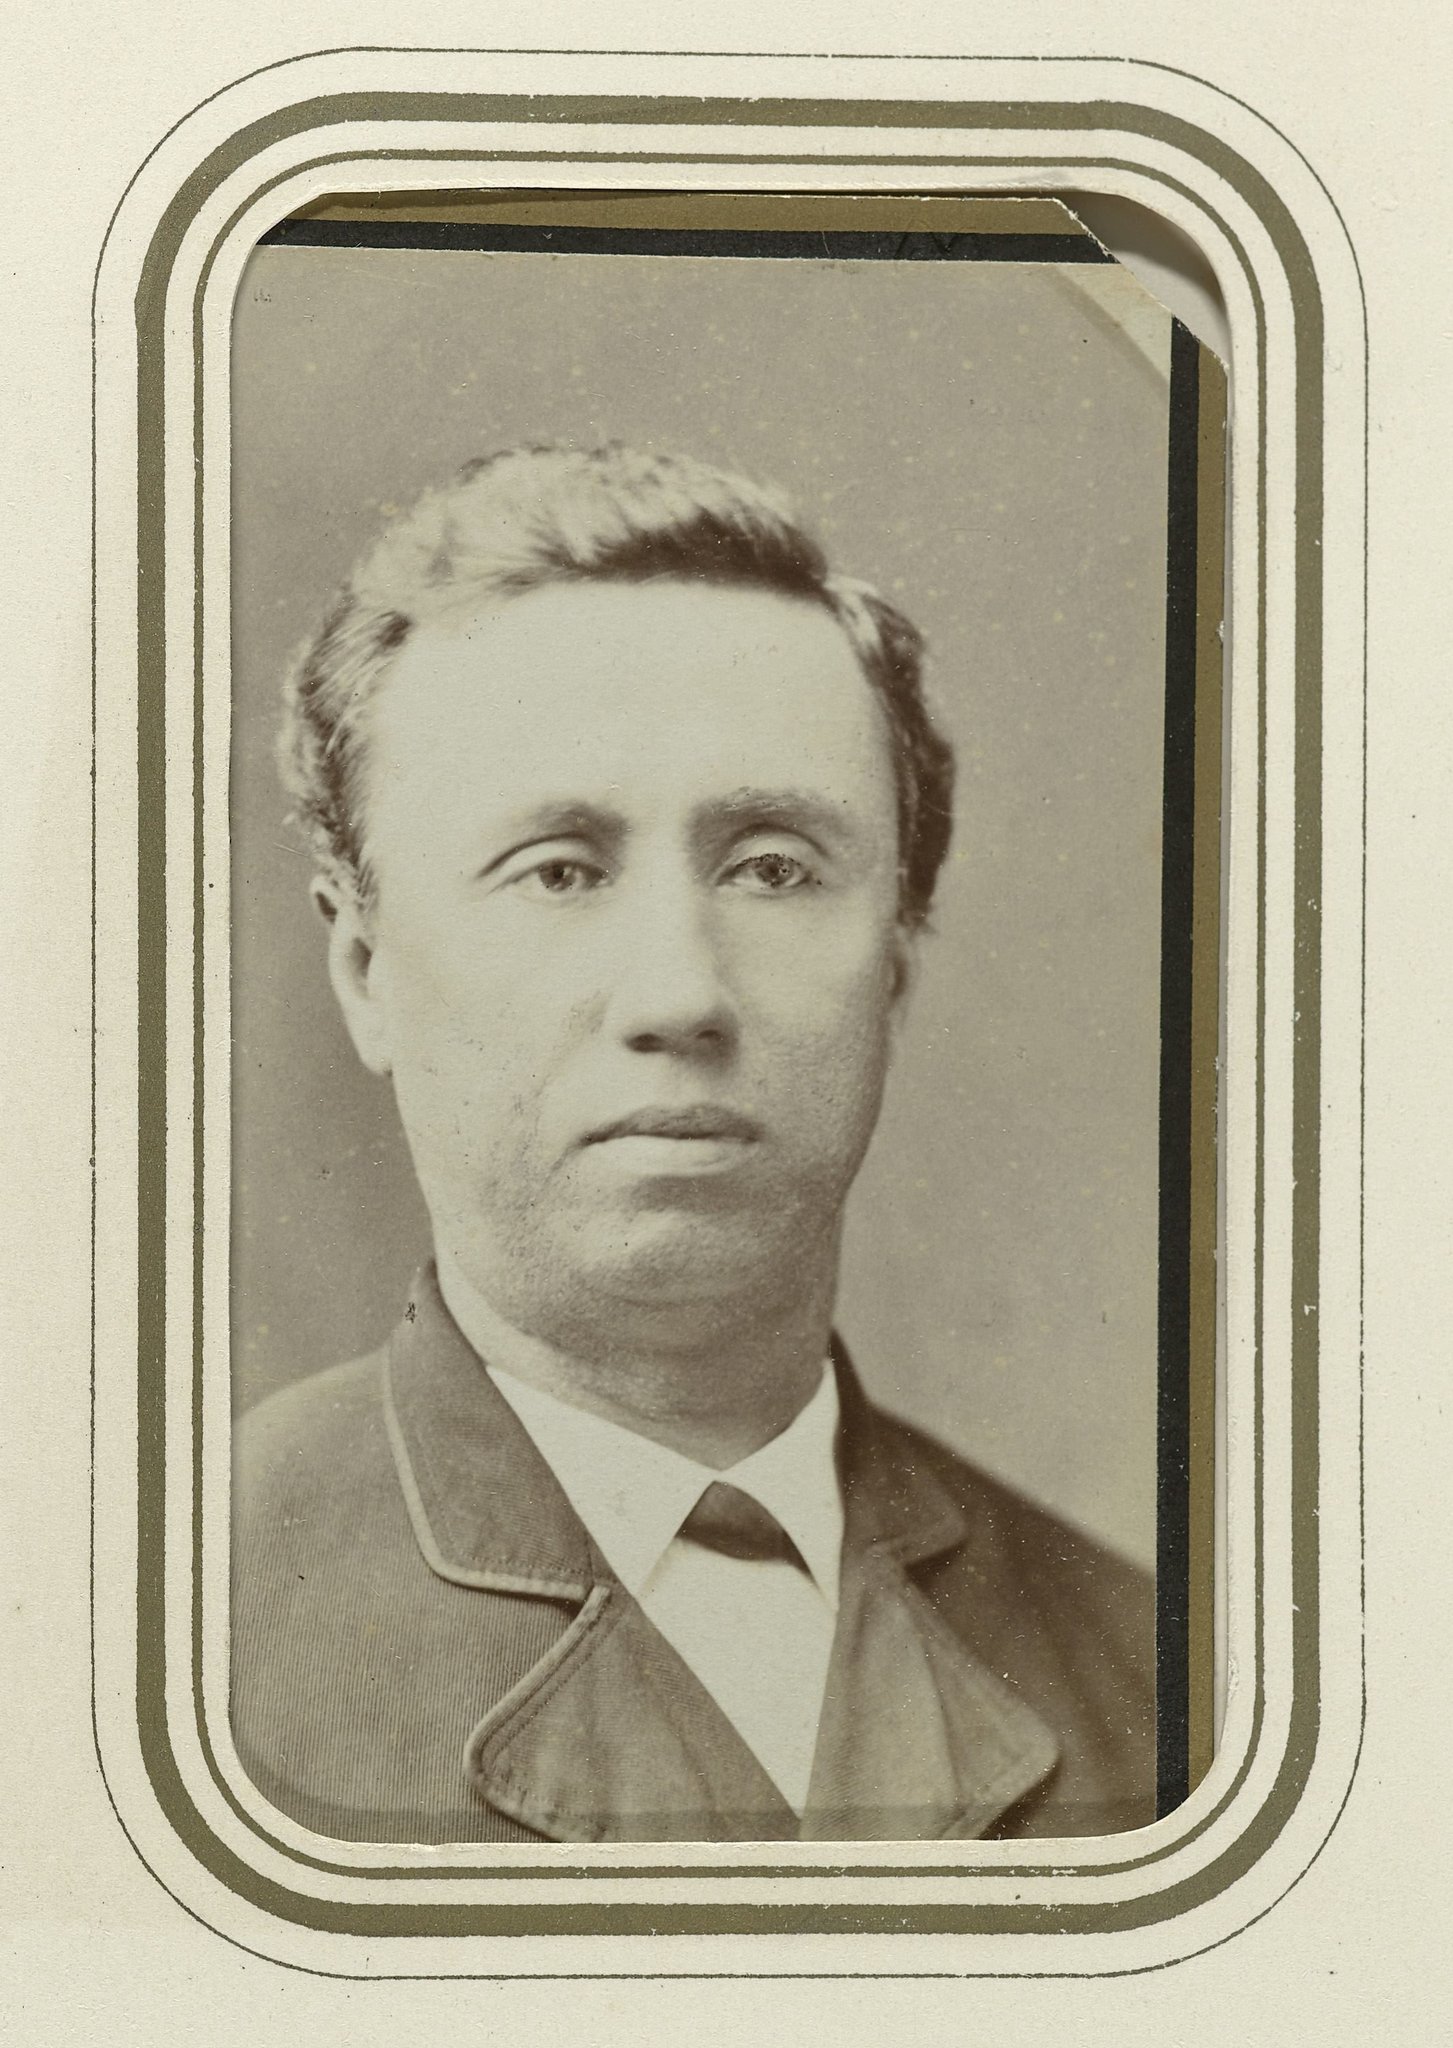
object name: photograph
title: Mansportret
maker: Anonymous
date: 1880-1886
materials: photographic support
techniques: photography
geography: dutch east indies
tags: the hague, anonymous historical person portrayed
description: Carte-de-visite met het portret van een onbekende man. Waarschijnlijk één van de aanbieders van het fotoalbum. Ingestoken in het fotoalbum aangeboden aan J.M. Pijnacker Hordijk bij zijn vertrek uit Jogyakarta in 1886.